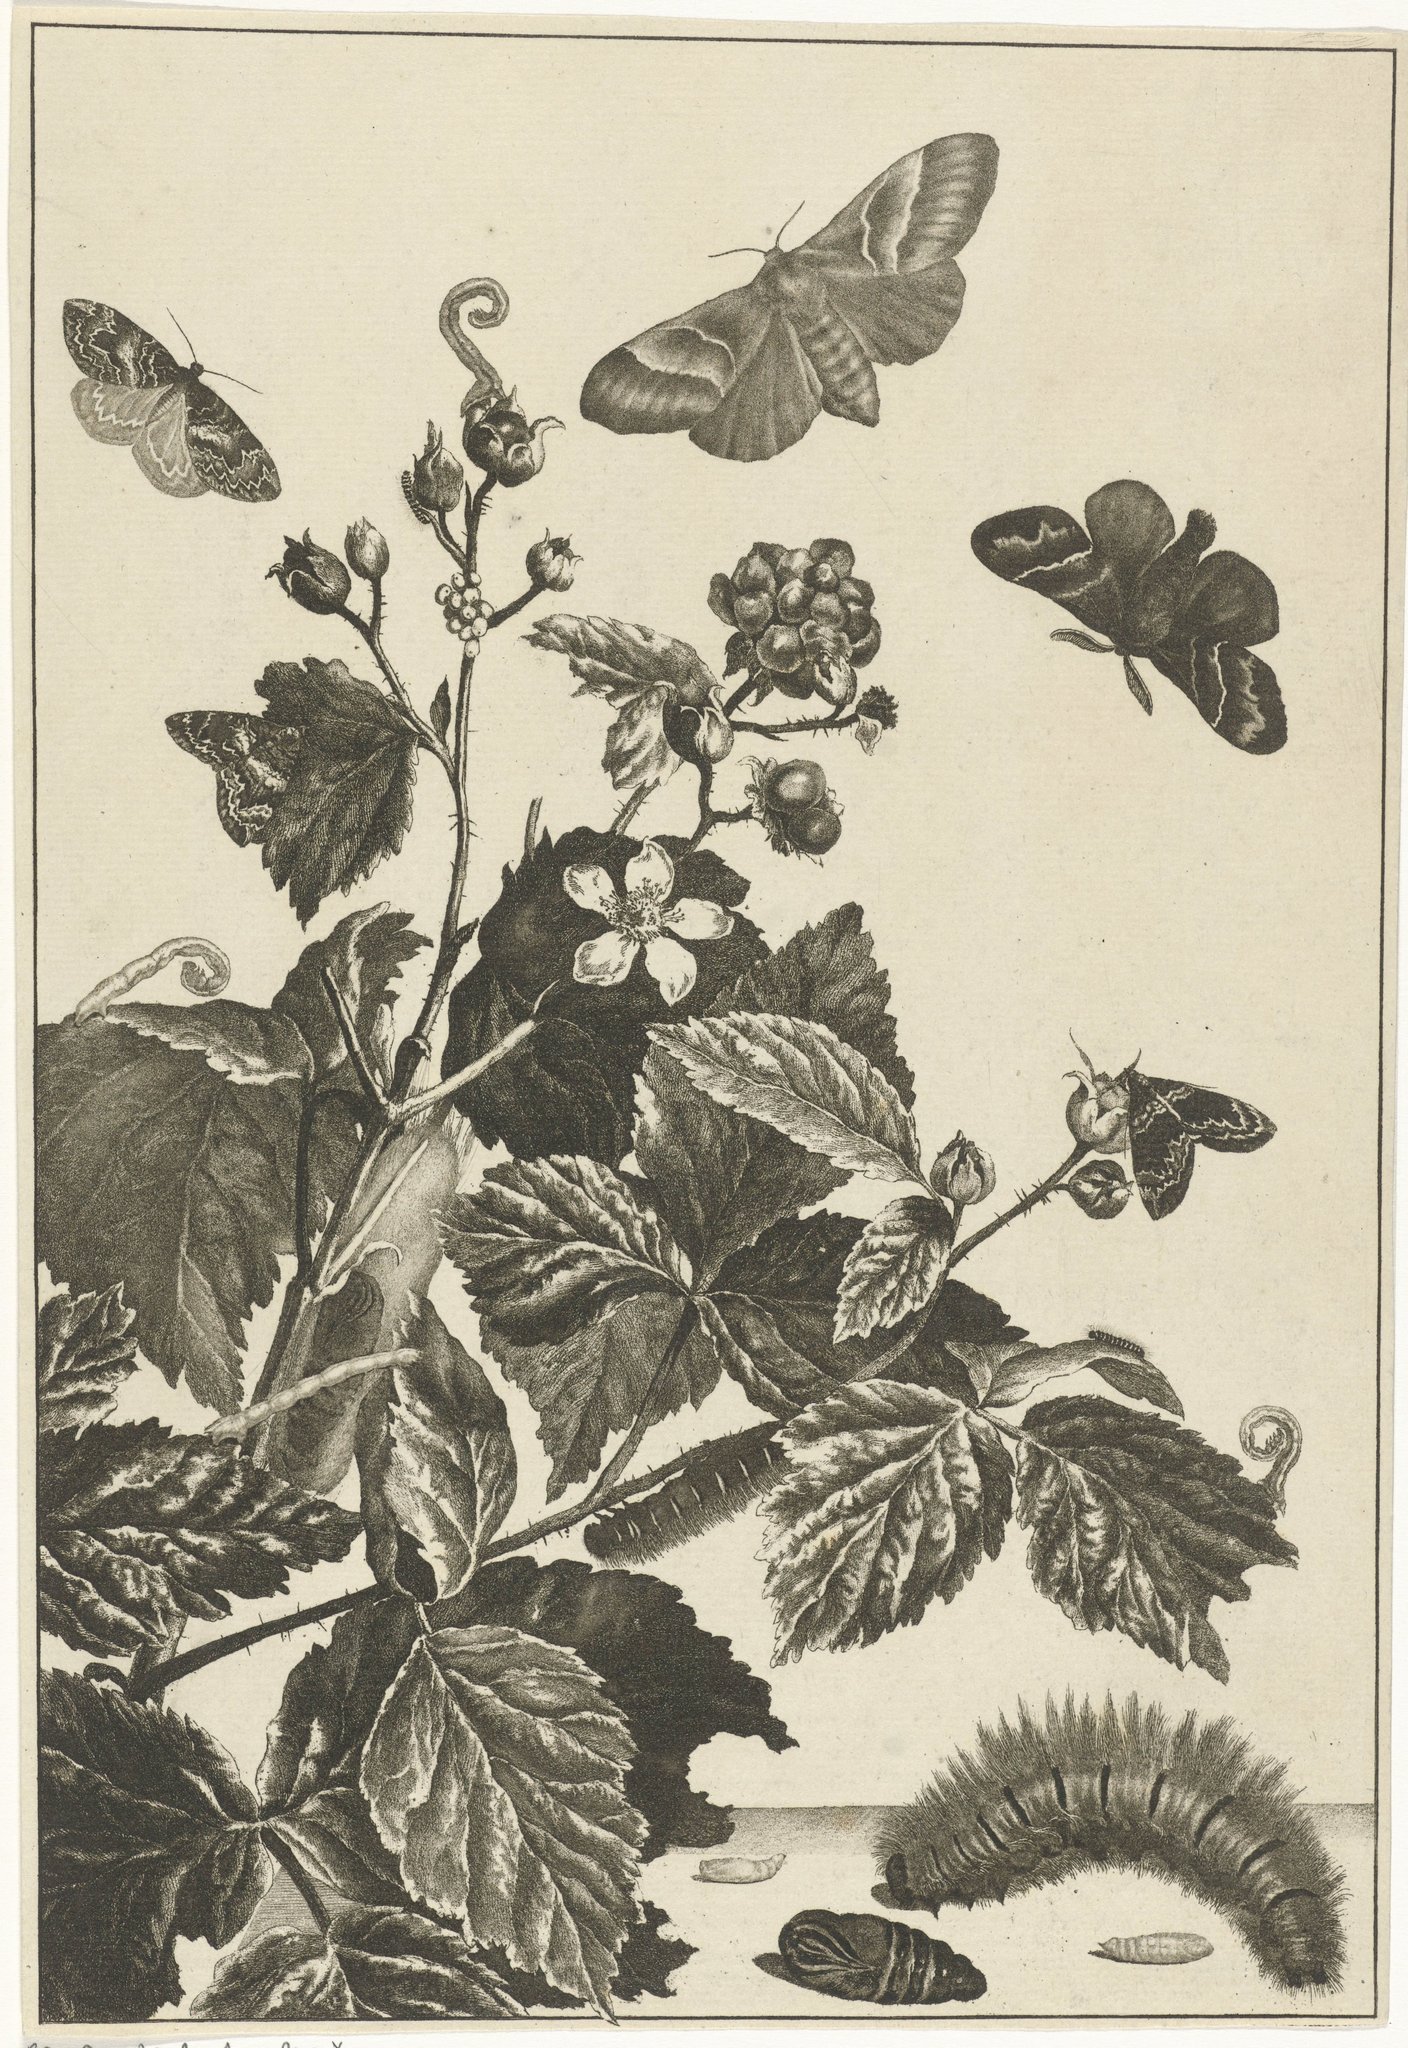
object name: book illustration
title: Wilde roos met rupsen en vlinders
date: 1710-1770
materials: paper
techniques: etching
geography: amsterdam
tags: insects: butterfly, flowers: rose, insects: caterpillar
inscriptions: collector's mark: Lugt 2228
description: Prent gebruikt in: L'Admiral, Jacob. Naauwkeurige waarneemingen omtrent de veranderingen van veele insekten of gekorvene diertjes. Amsterdam: Johannes Sluyter, 1774.